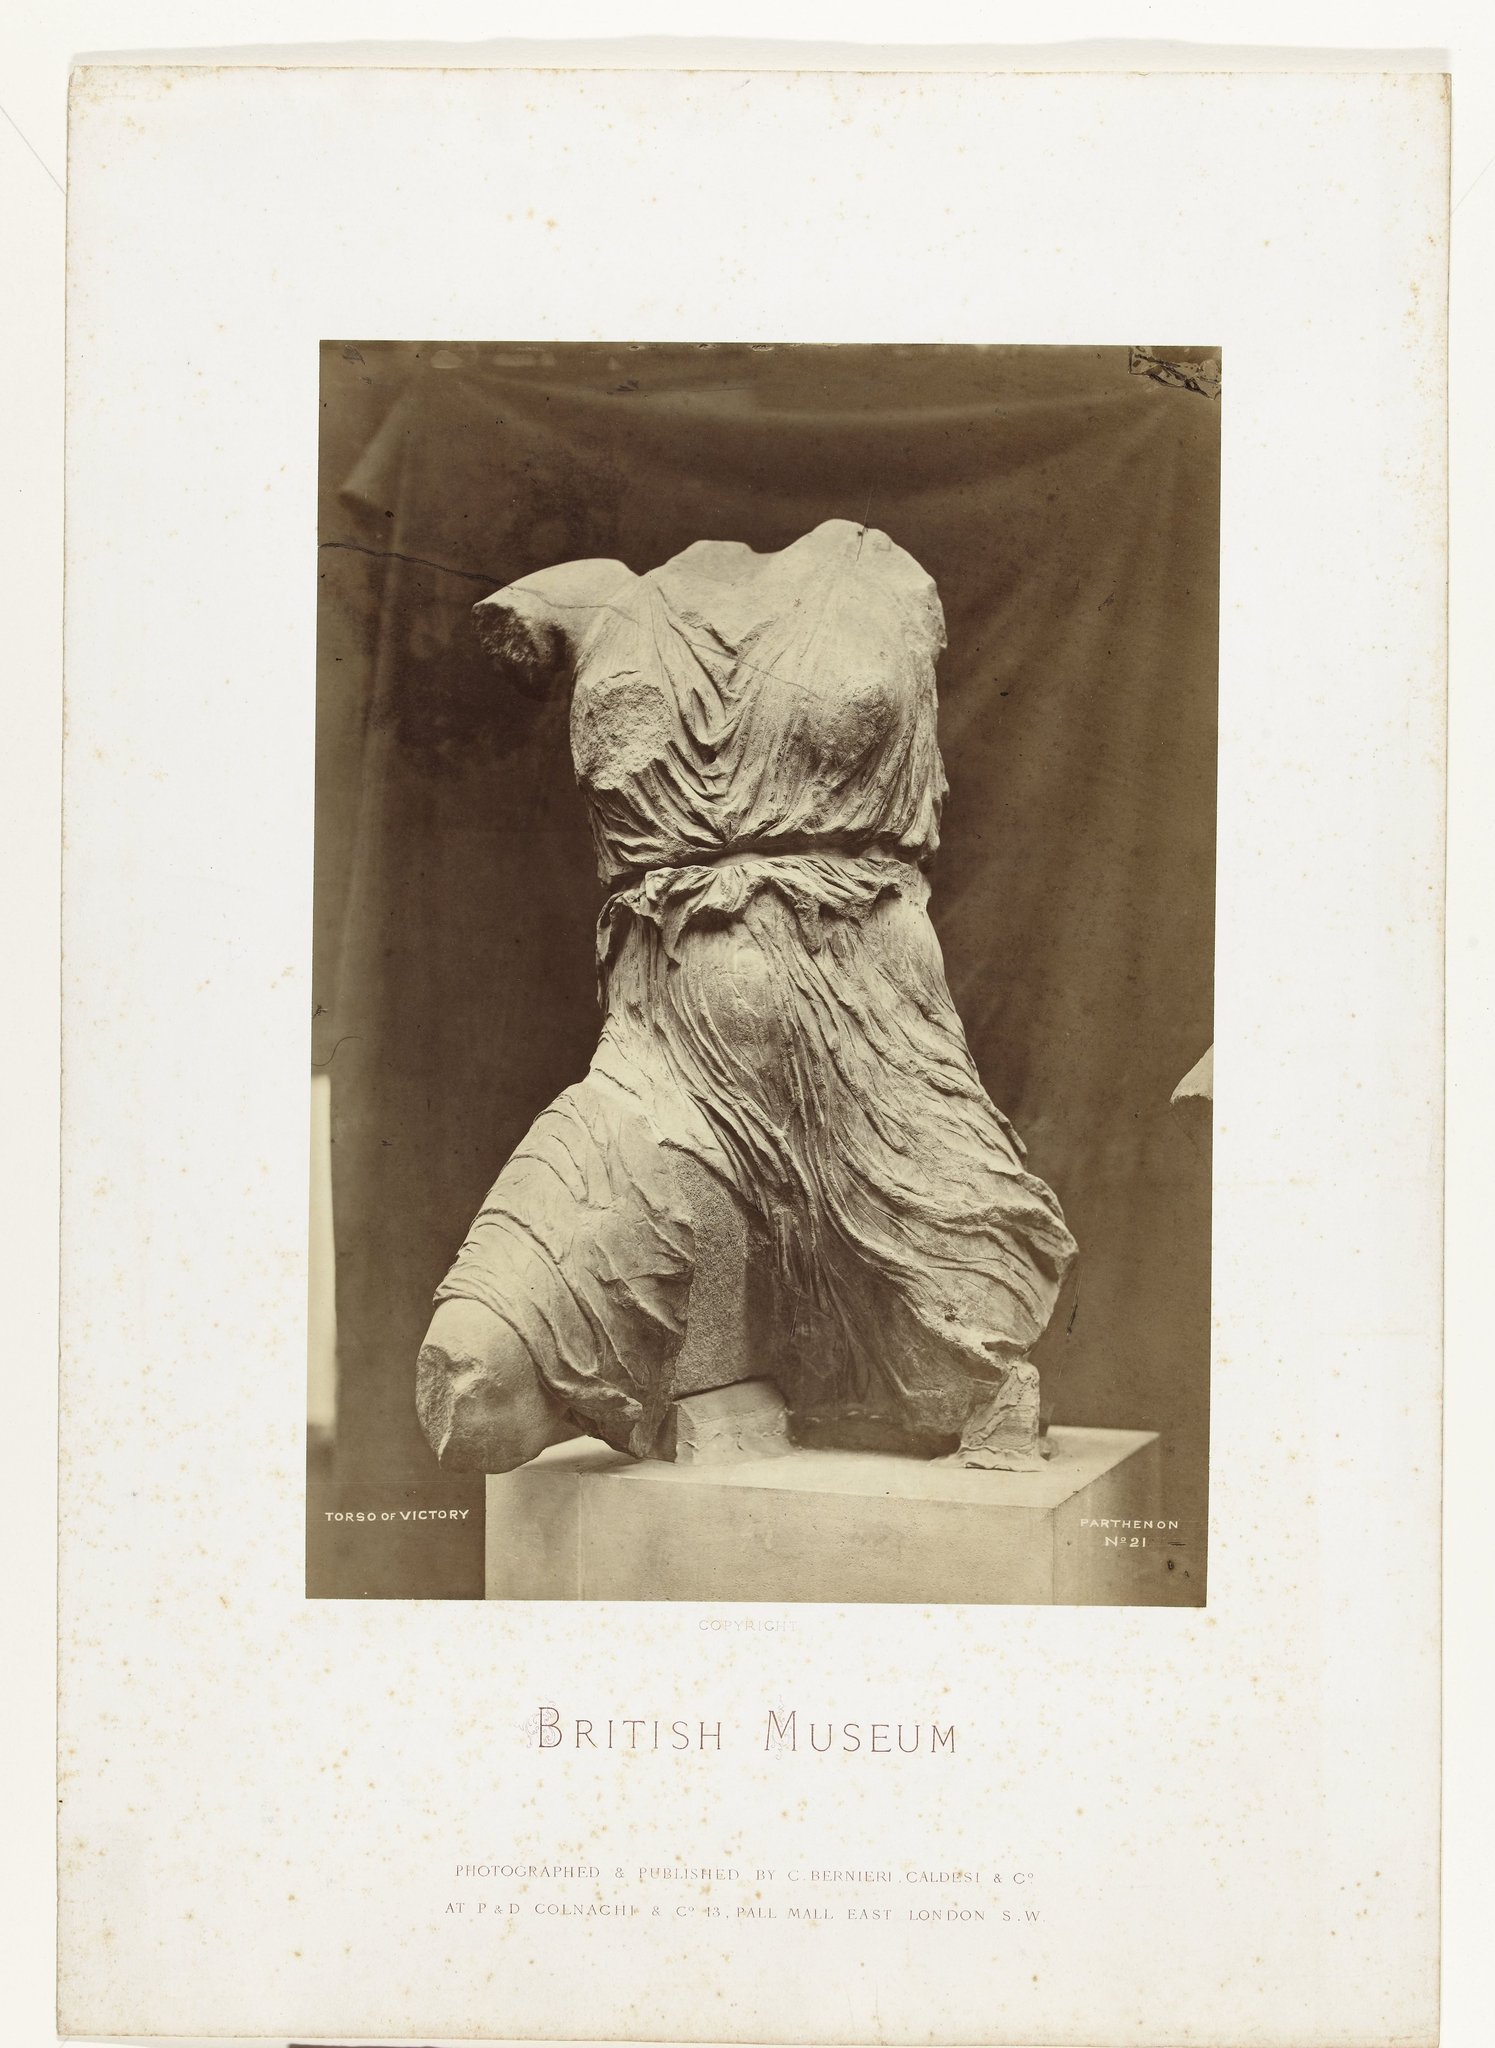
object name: photograph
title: Torso of Victory Parthenon No 21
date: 1857-1859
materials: cardboard, photographic support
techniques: albumen print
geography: london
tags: piece of sculpture, reproduction of a piece of sculpture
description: Sculptuur van de torso van Nike, afkomstig van het Parthenon